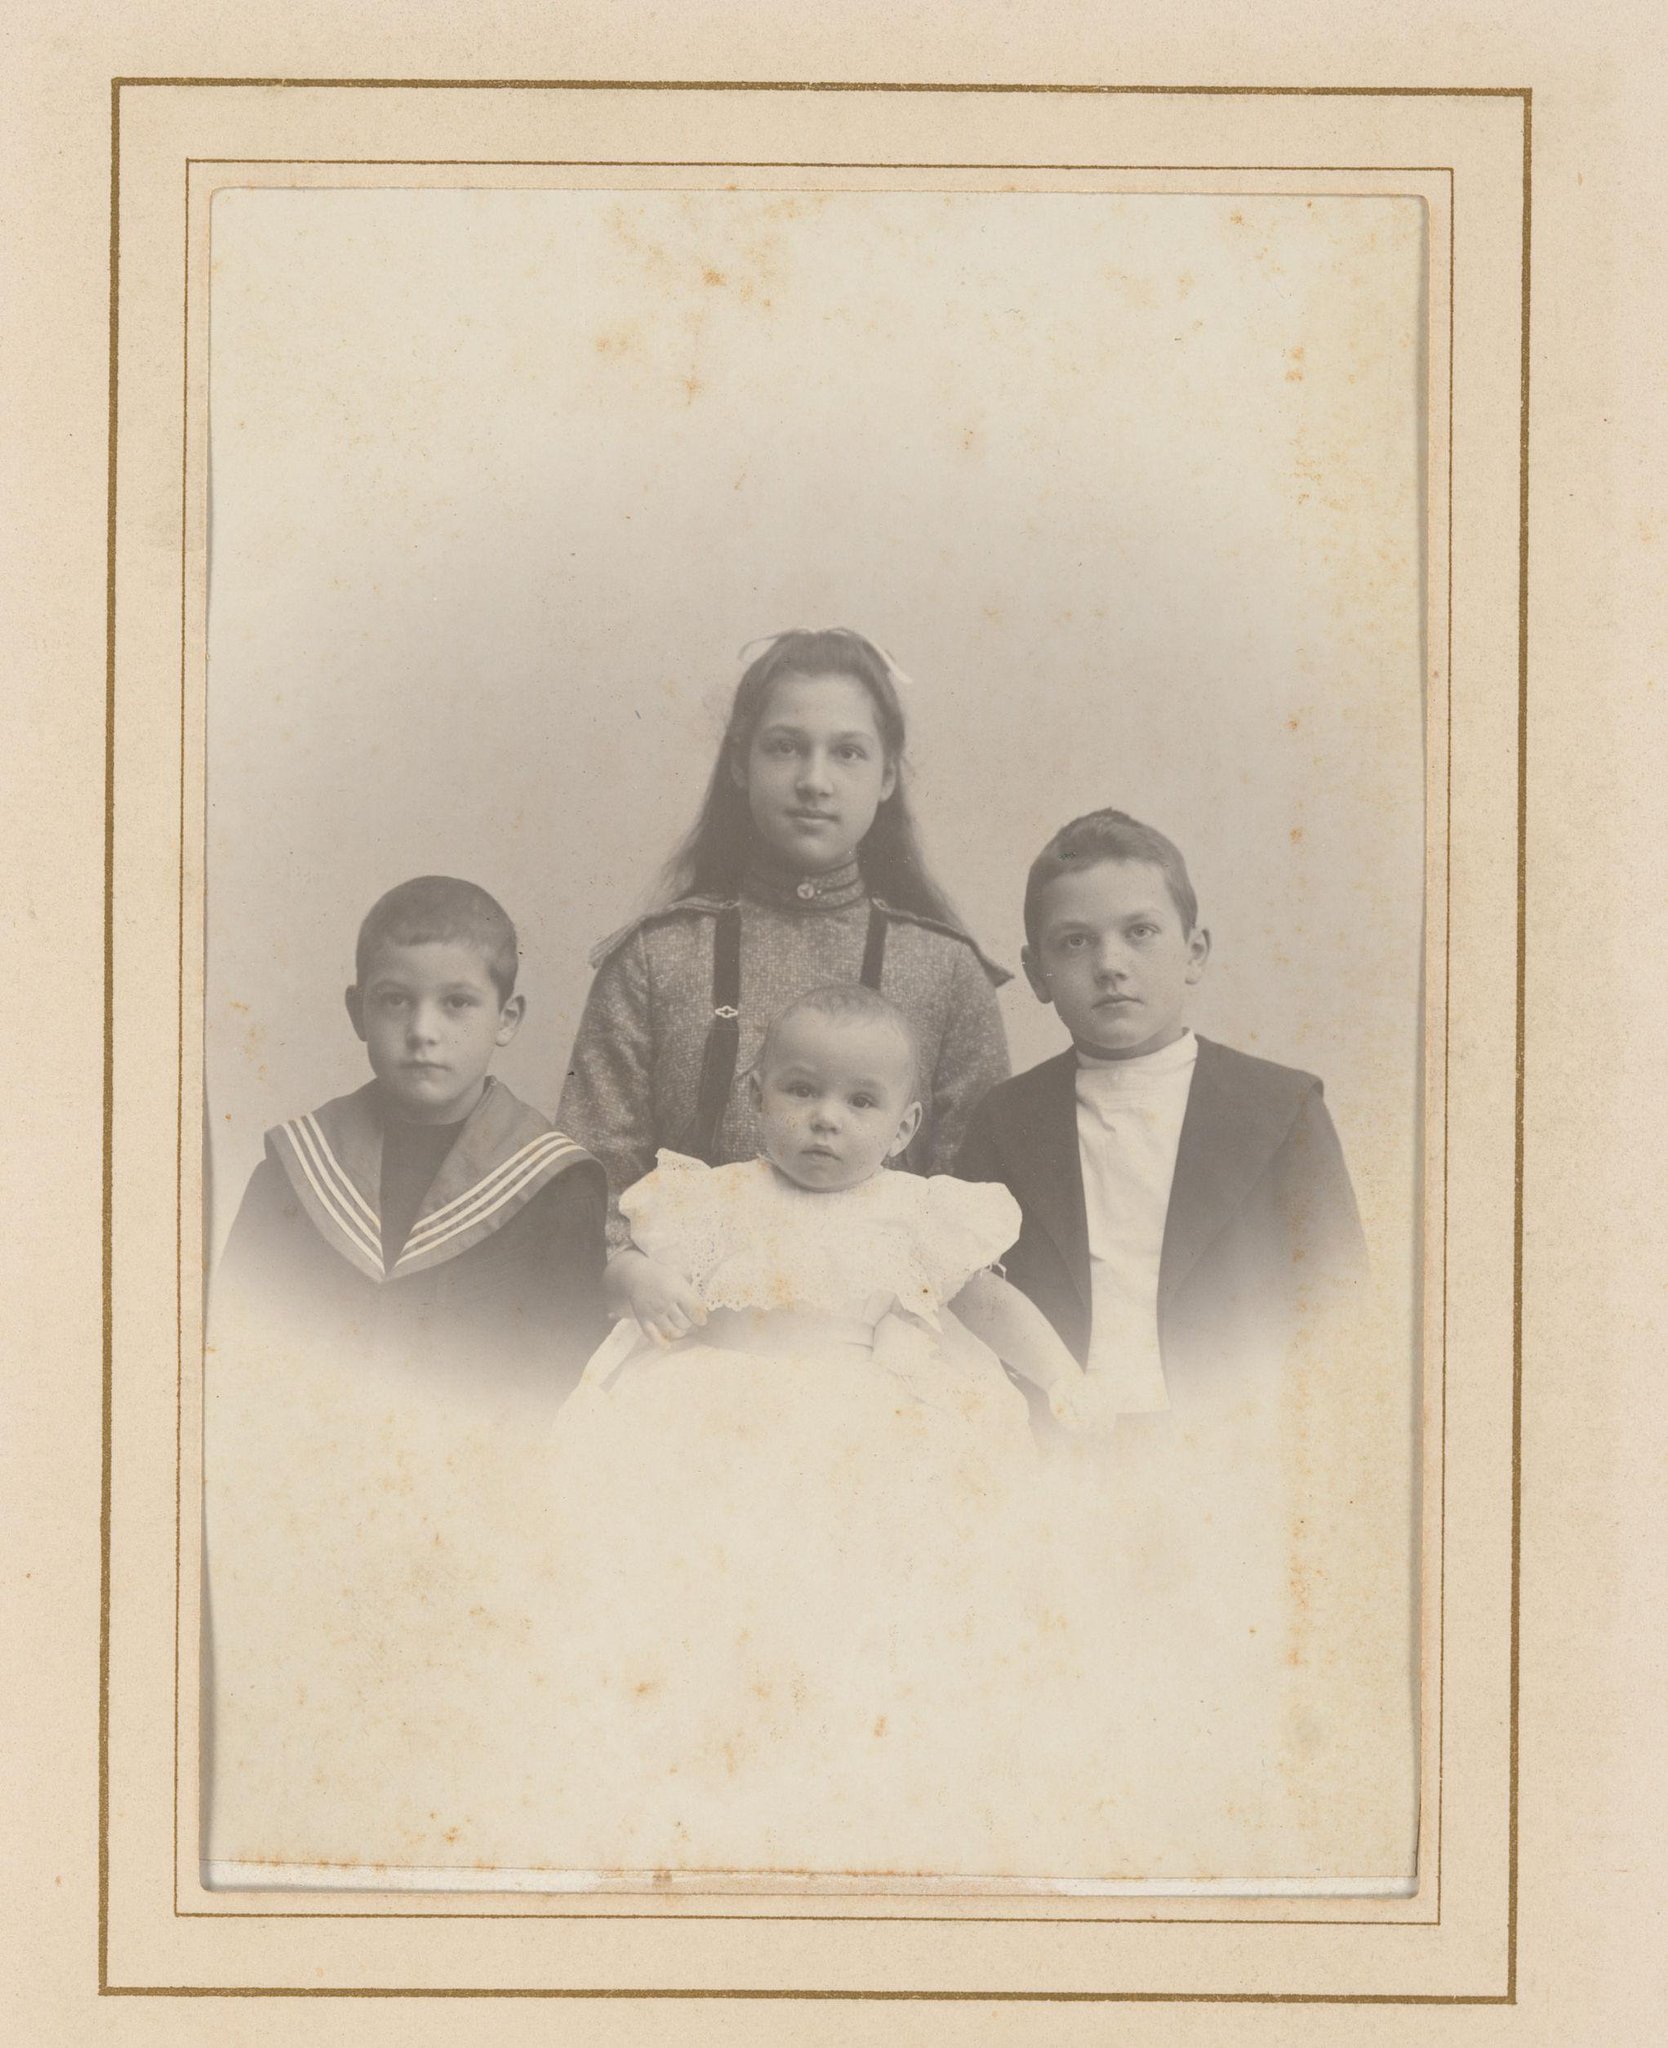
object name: album leaf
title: Groepsportret van een meisje, twee jongens en een baby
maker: franciscus g. lukera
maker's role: fotograaf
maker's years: 1853-1927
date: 1903-1912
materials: cardboard, photographic support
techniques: collodion silver print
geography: amsterdam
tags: boy (child between toddler and youth) (+ two persons), girl (child between toddler and youth), infant, baby ~ the ages of man, anonymous historical persons portrayed in a group, in a group-portrait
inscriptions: inscription: ‘F. Lukera/ Photograaf/ Ceintuurbaan 187/ bij de van Woustraat/ Amsterdam/ Speciale Inrichting voor Vergrootingen.’, annotation: ‘1903/ Decbr/ Lena 13 jaar/ Au[g]o 12 ,,/ Floris 7 ,,/ Lizer 1 ,,’